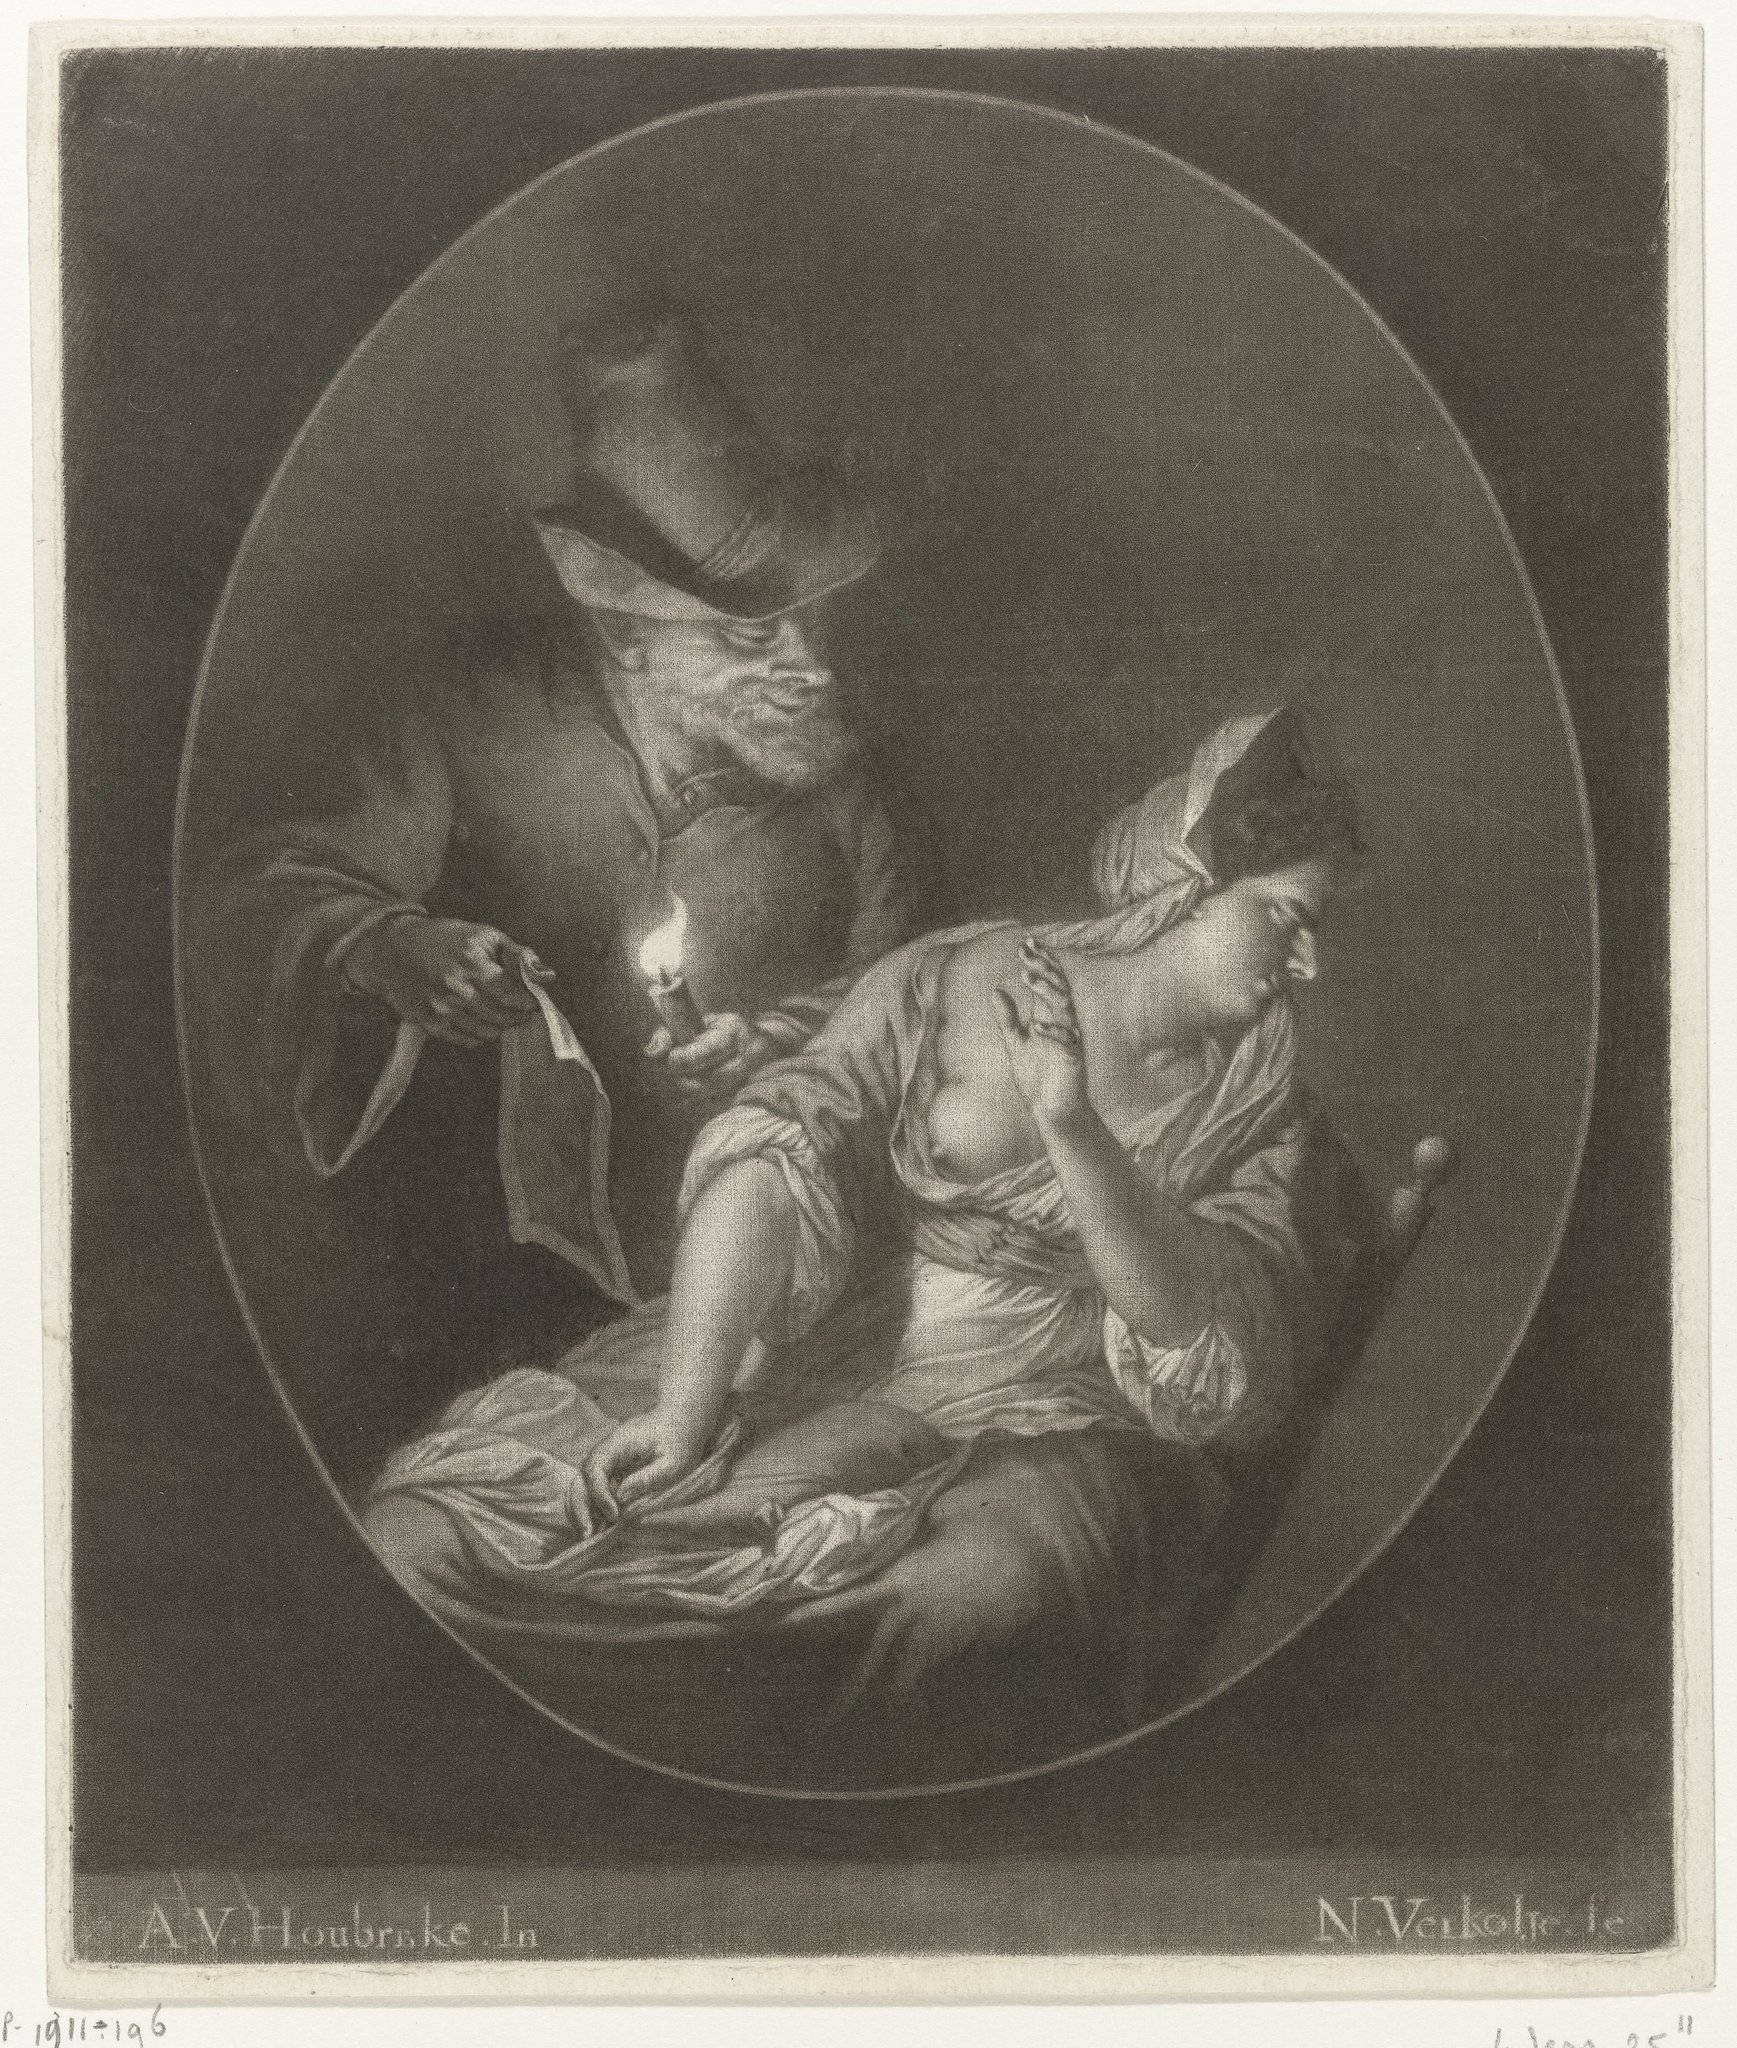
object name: print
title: Man toont een prent aan een vrouw, bij kaarslicht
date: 1683-1746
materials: paper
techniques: mezzotint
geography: amsterdam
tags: print, e.g.: engraving, etching, lithograph, home sewing; repair of clothes, candlestick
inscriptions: collector's mark: Lugt 2228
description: Een man toont, bij het licht van een kaars, een prent aan een vrouw die van de prent weg kijkt. Haar decolleté is half ontbloot. Op haar schoot ligt een naaikussen en stof.